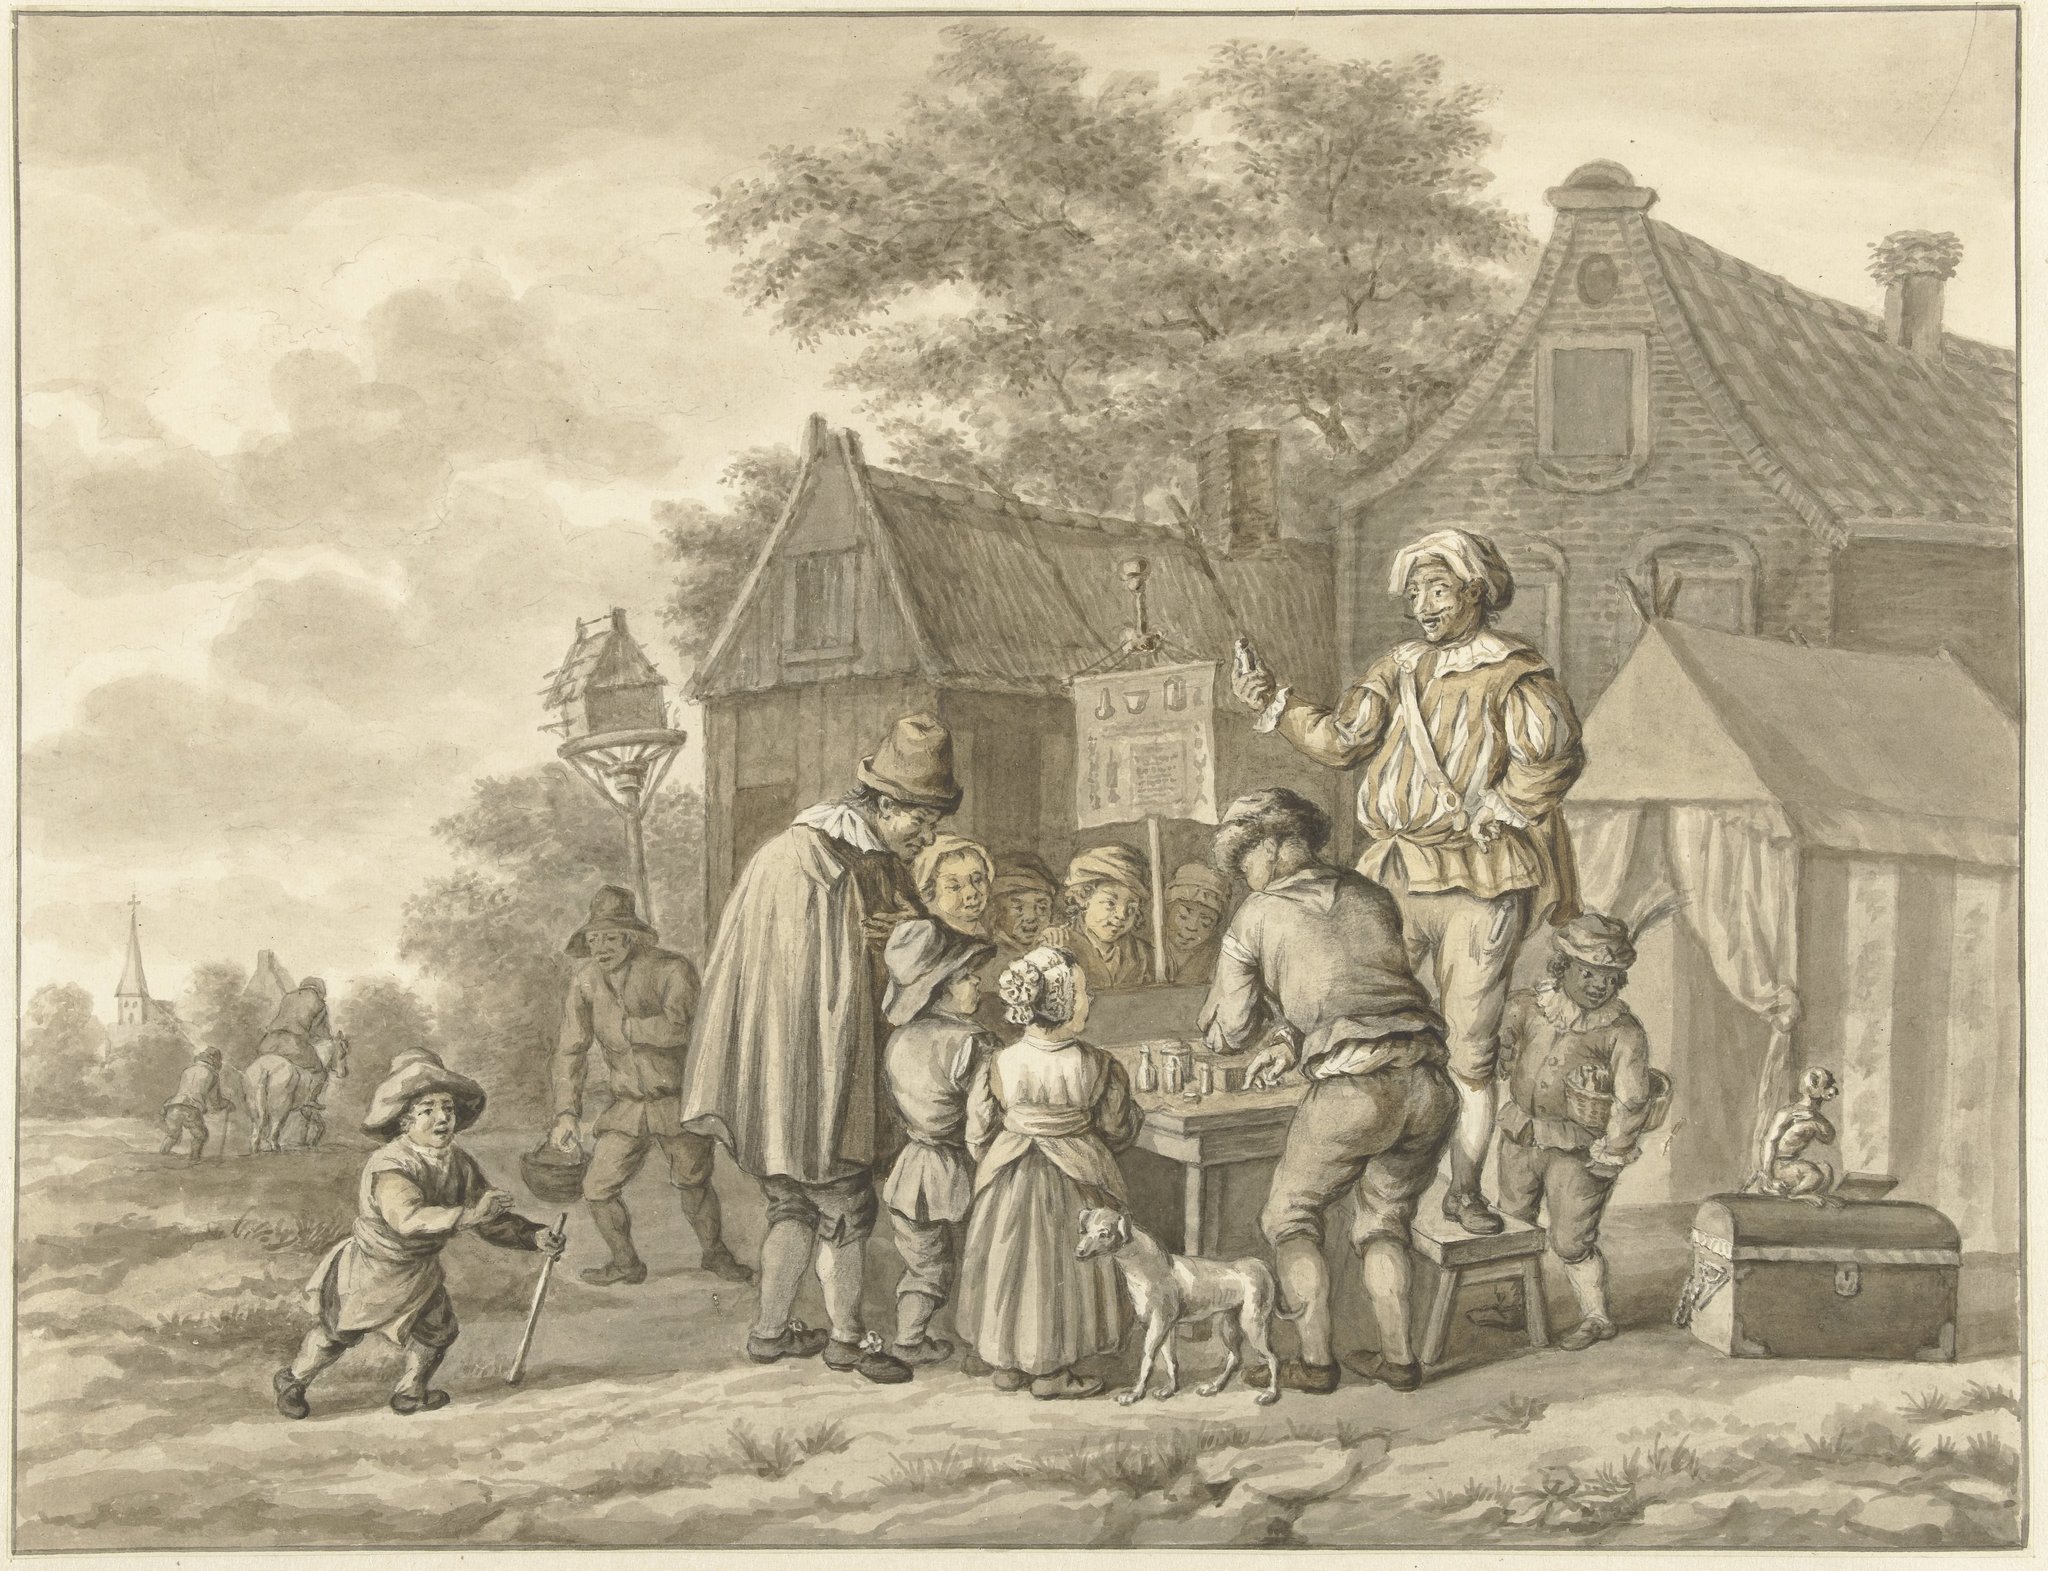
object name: drawing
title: Kwakzalver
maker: abraham delfos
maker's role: draughtsman, painter, print maker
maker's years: 1731-1820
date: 1741-1820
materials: chalk, paper, pencil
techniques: brush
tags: quack, charlatan, mountebank, 'saltimbanco'